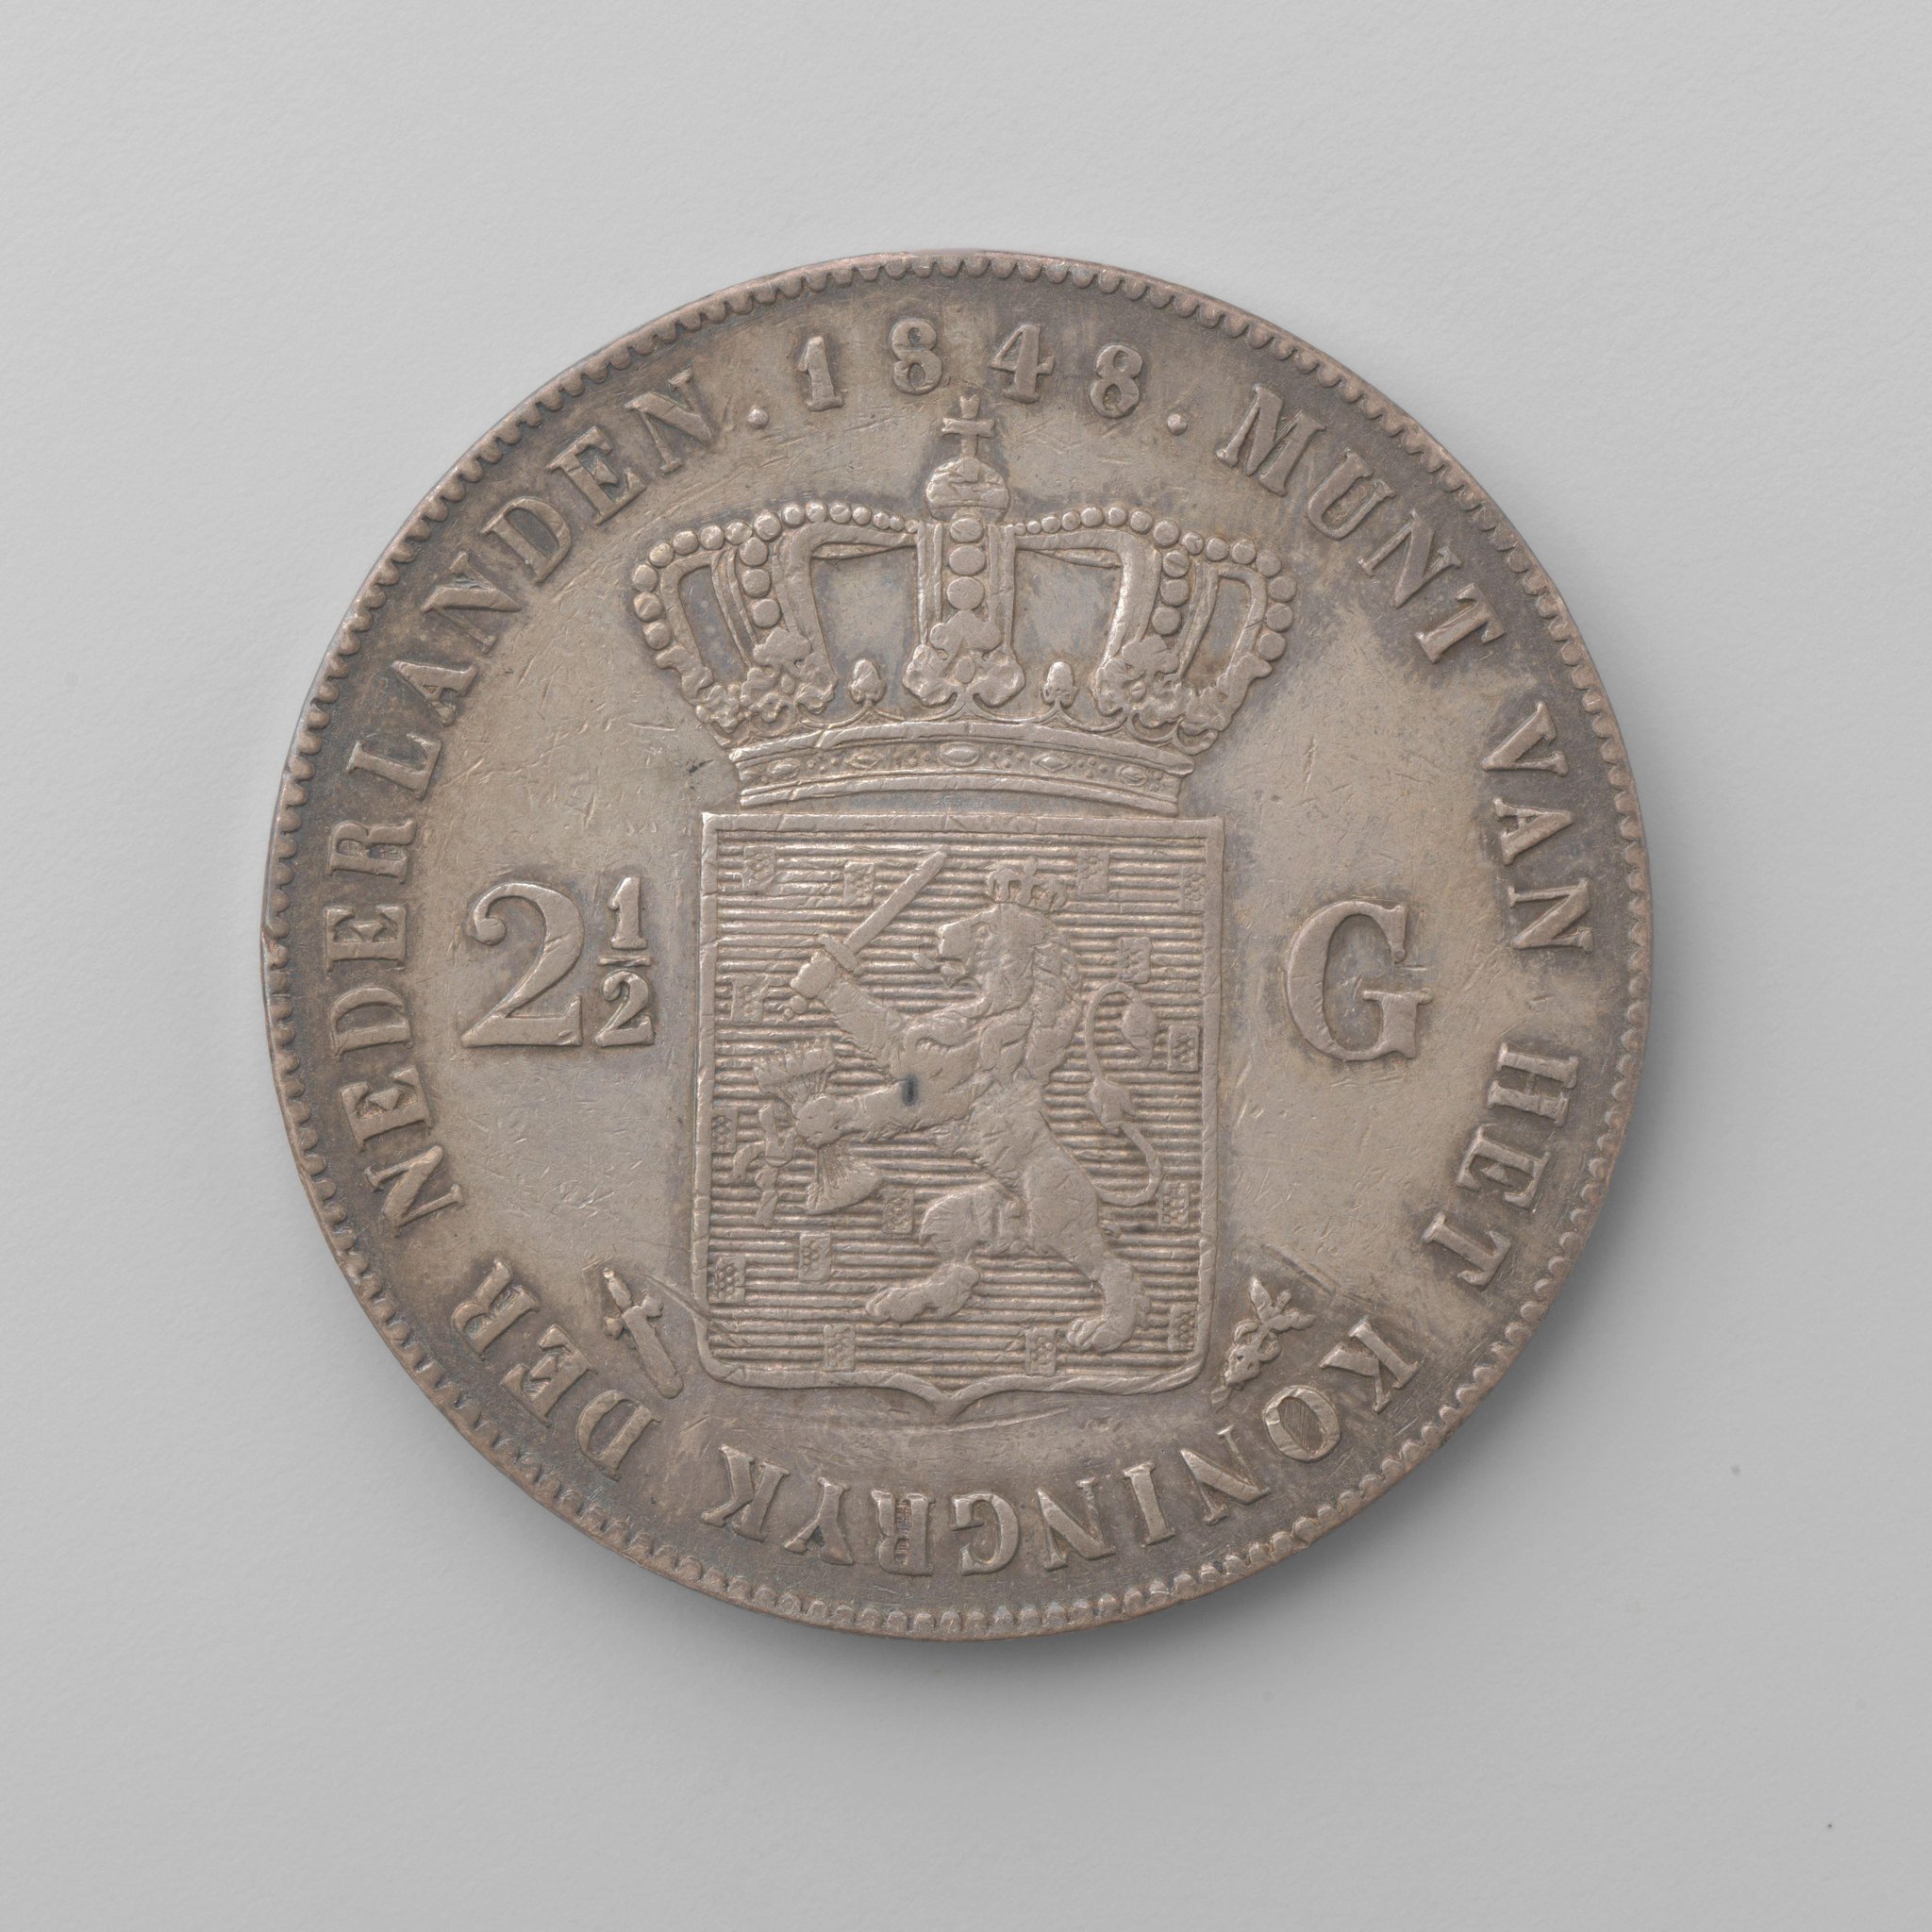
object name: coin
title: Nederlandse 2½ gulden, 1848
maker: william ii of the netherlands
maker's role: koning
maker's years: 1792-1849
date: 1848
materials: silver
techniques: striking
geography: utrecht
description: Zilveren munt. Voorzijde: borstbeeld naar links. Keerzijde: tussen waarde-aanduiding 2½ G gekroond rijkswapenschild. Jaartal boven kroon. Randschrift.